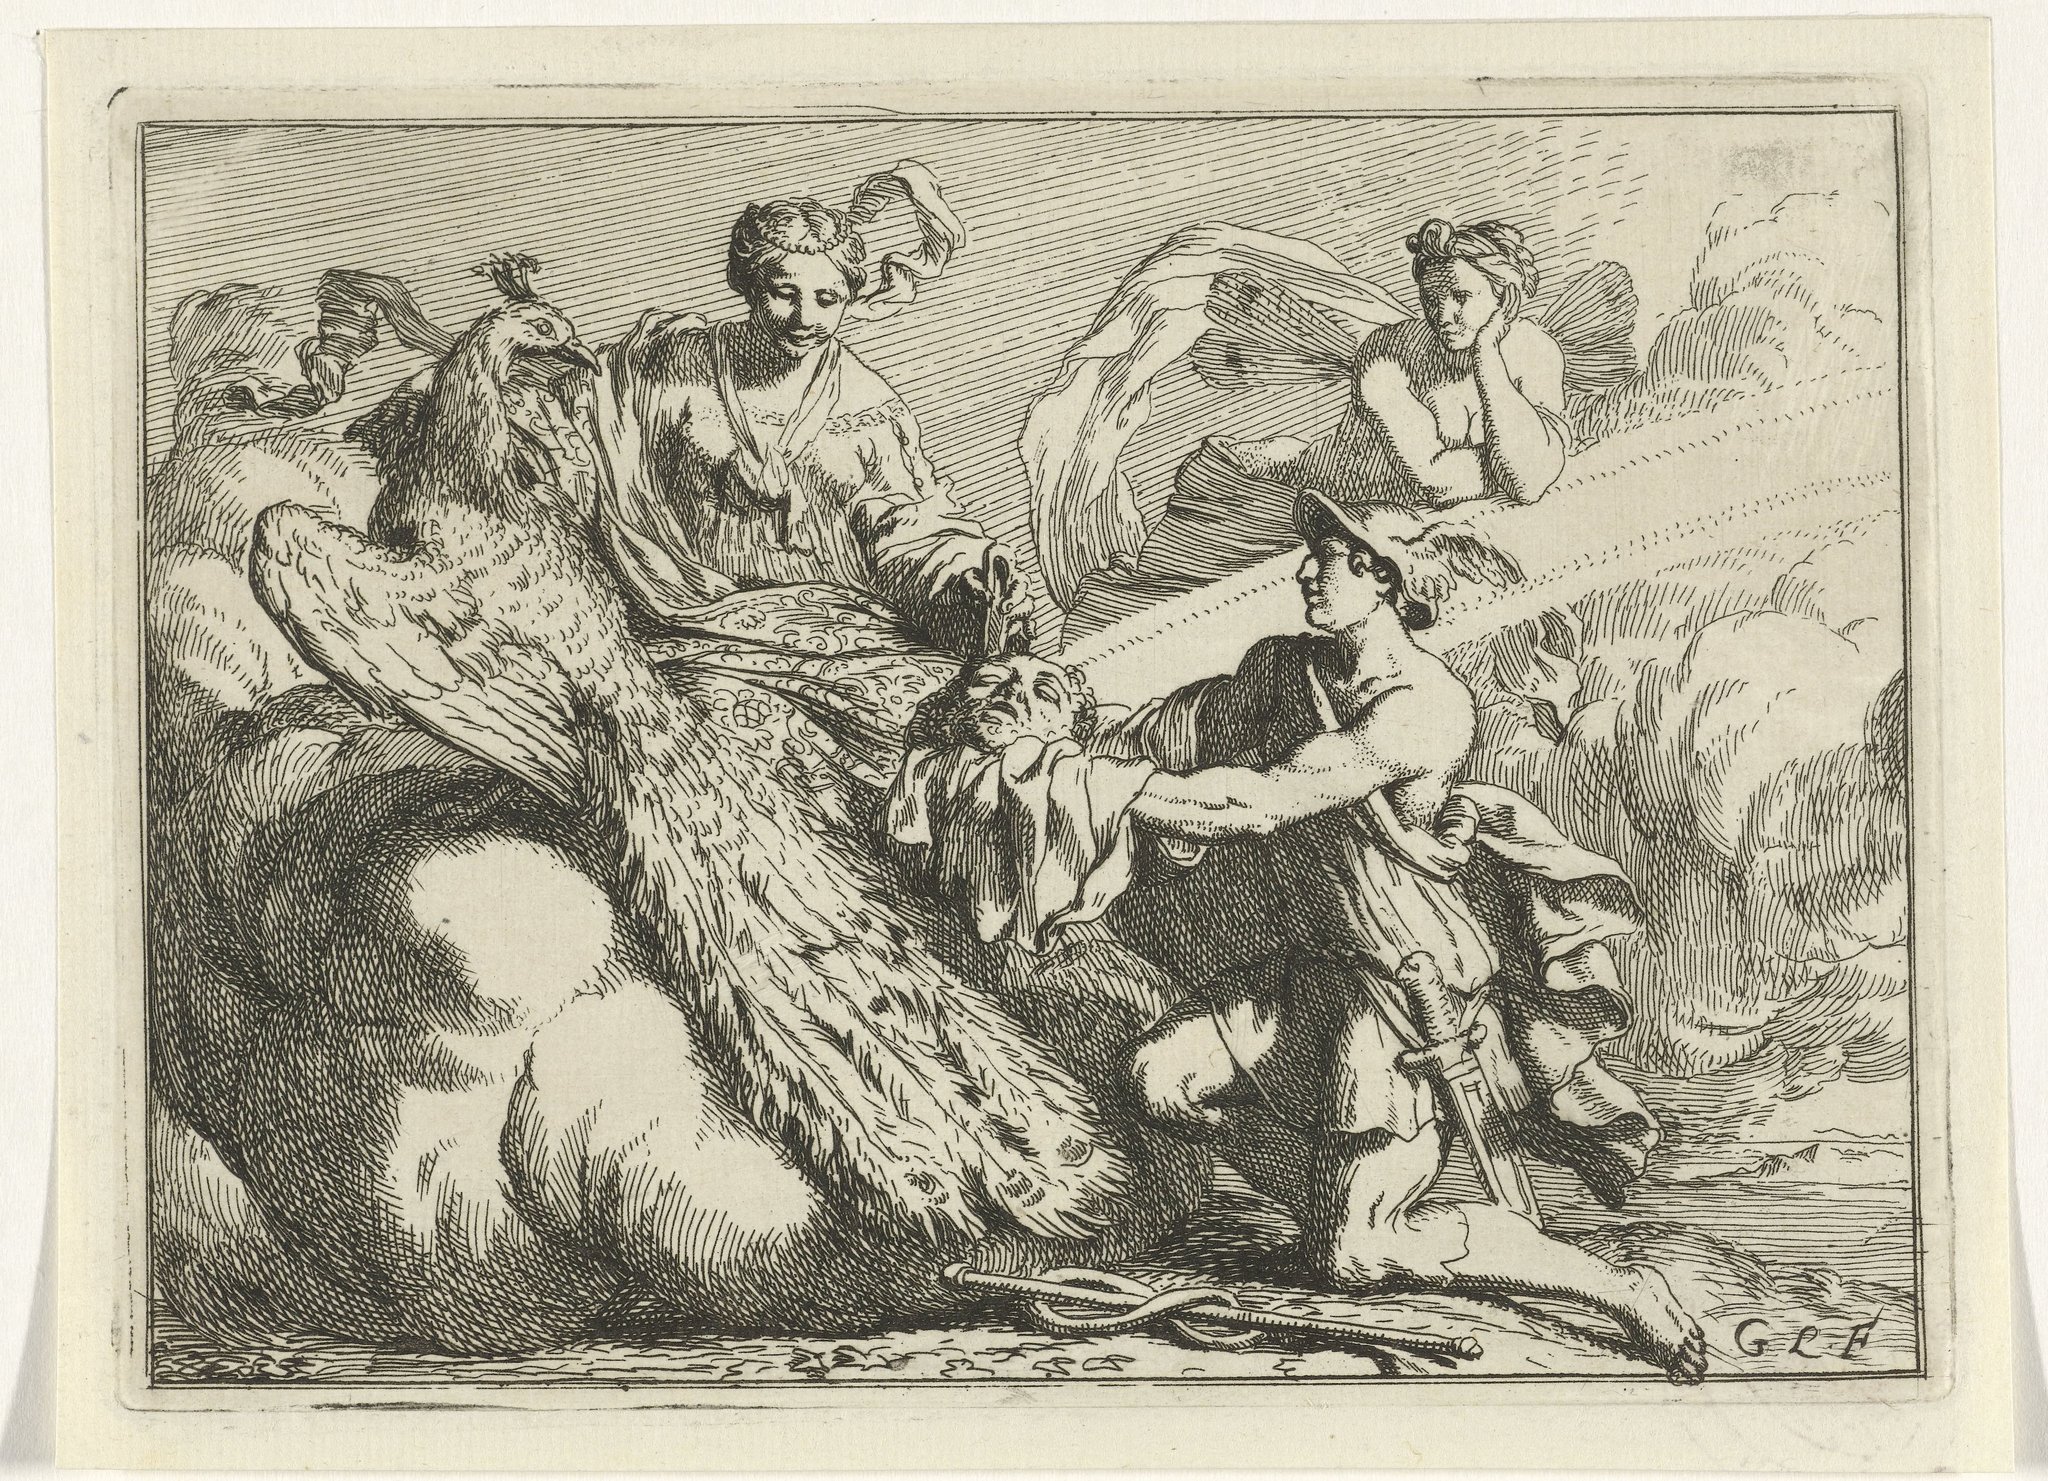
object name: print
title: Geschiedenis van Argus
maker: gerard de lairesse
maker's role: draughtsman, painter, print maker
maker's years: 1641-1711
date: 1670-1672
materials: paper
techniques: etching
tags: mercury bringing argus' eyes to juno; juno sets argus' eyes in the tail of her peacock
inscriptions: collector's mark: Lugt 240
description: De honderdogige reus Argus, die van Juno Io moest bewaken, werd gedood door Mercurius. Ter nagedachtenis aan Argus nam Juno zijn ogen en zette ze in de staart van haar pauw. Mercurius houdt het afgehakte hoofd van Argus vast terwijl Juno de ogen één voor één eruit haalt en ze op de veren van haar pauw plaatst. De prent maakt deel uit van een vierdelige serie prenten met scènes uit het mythologische verhaal van Argus